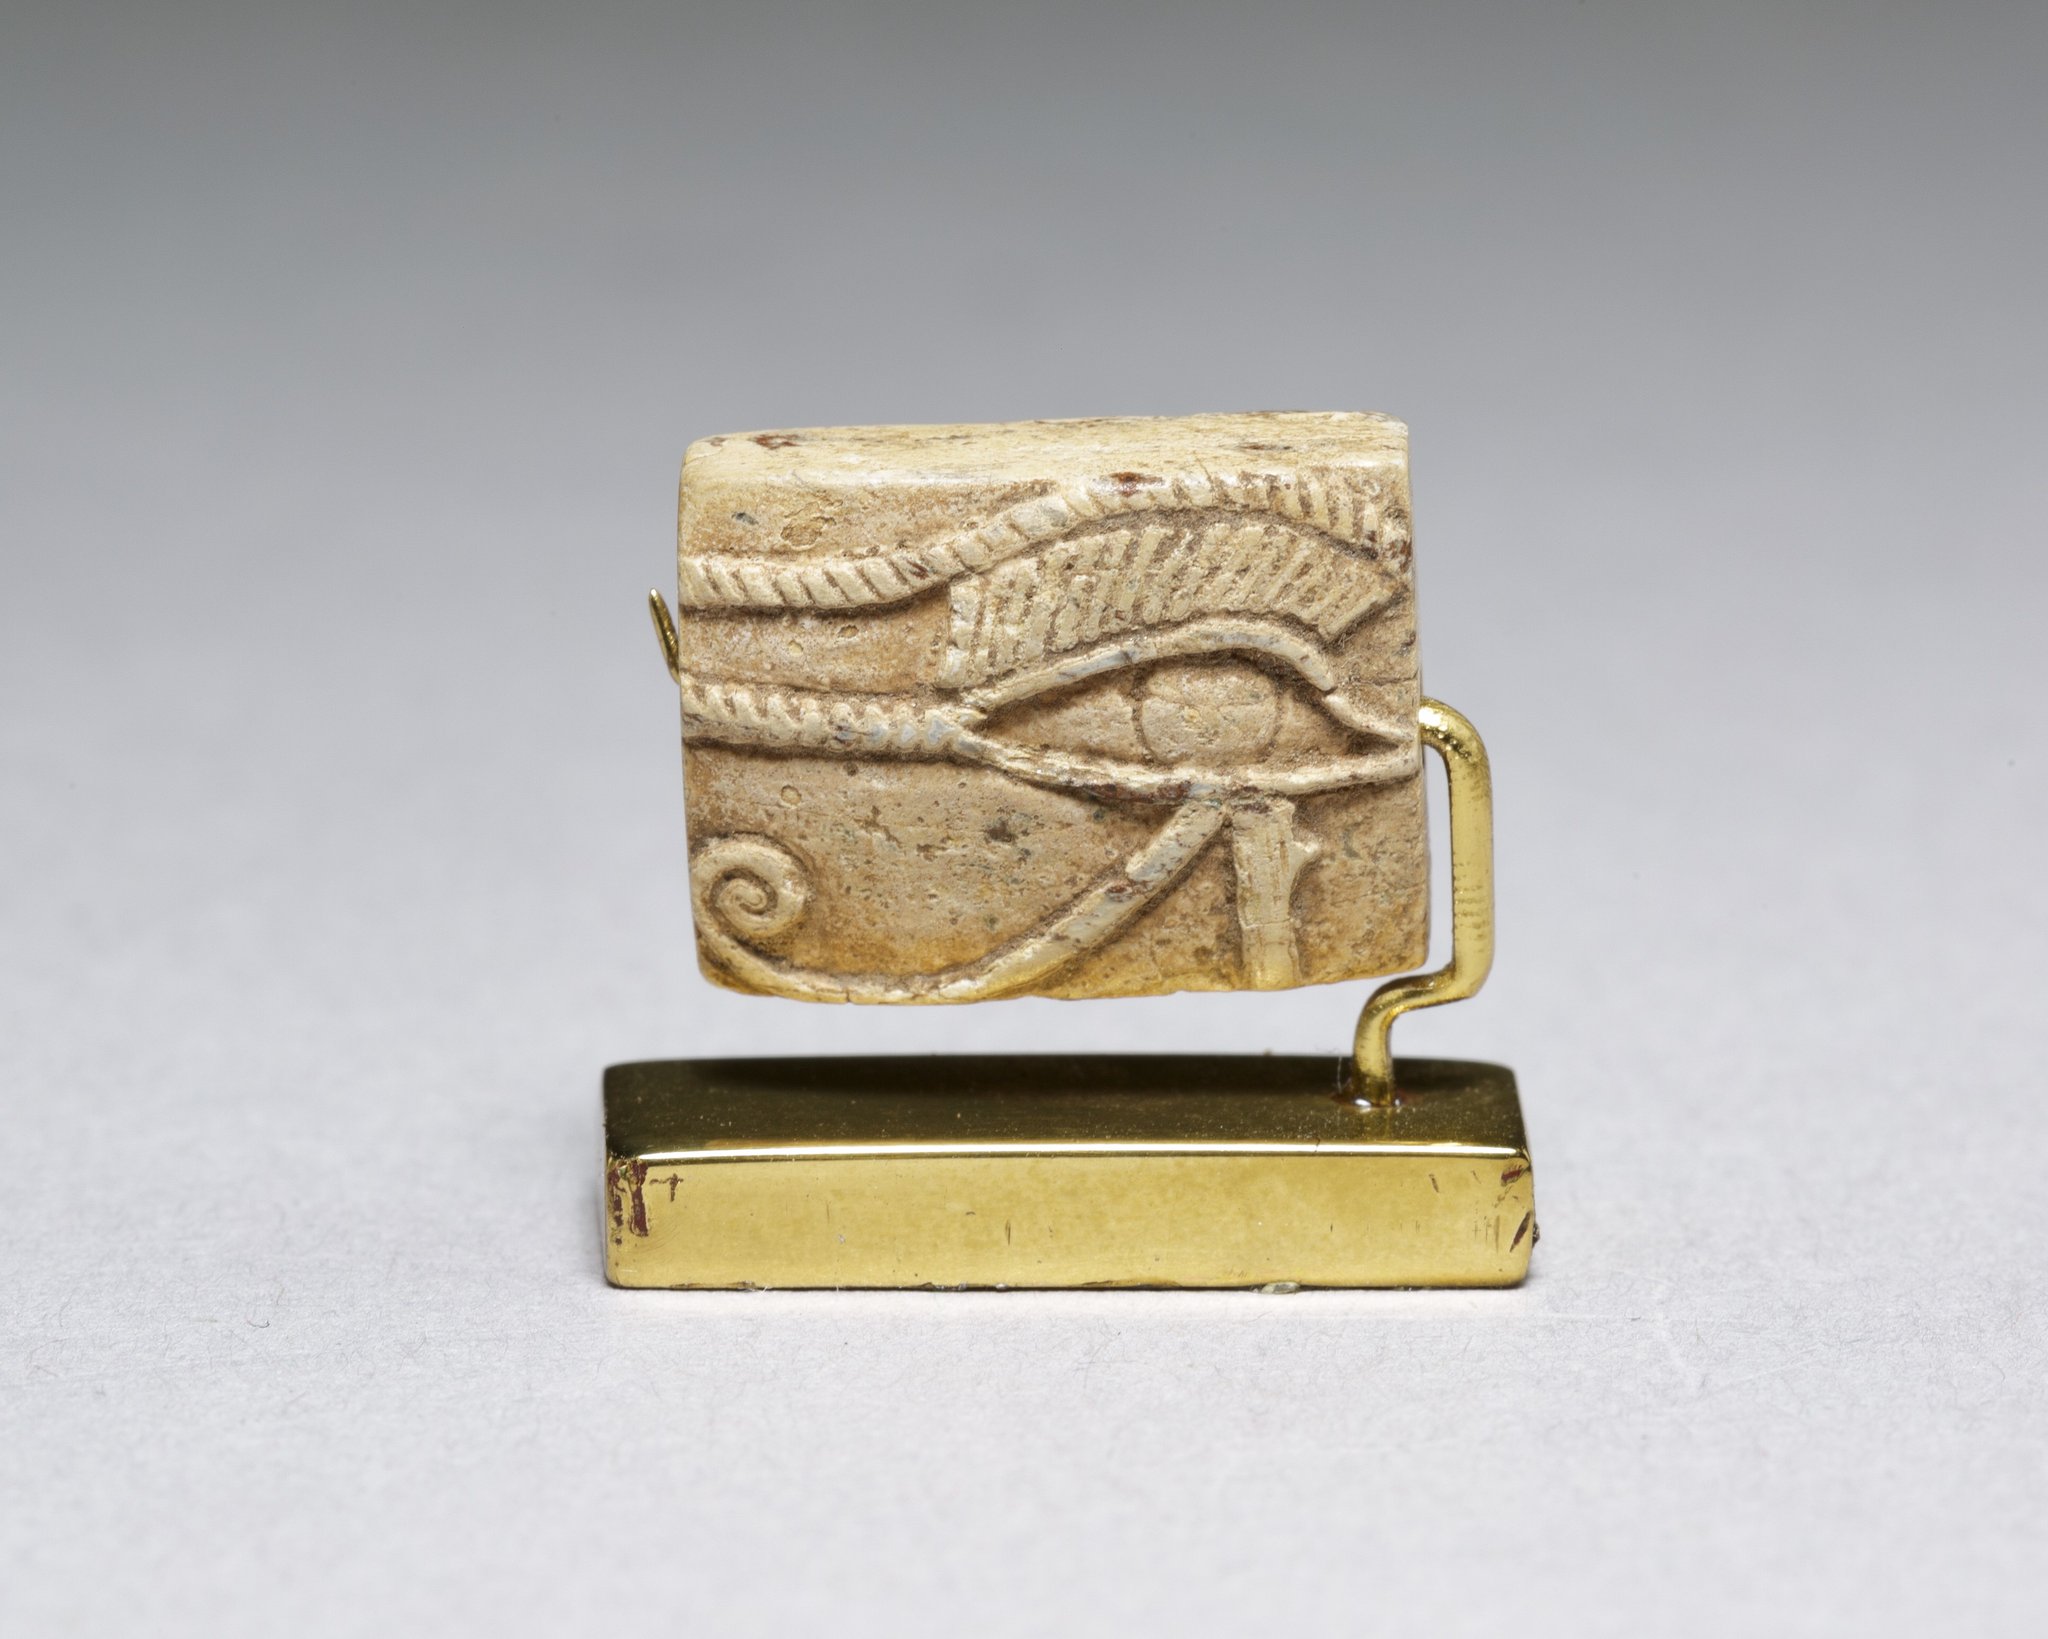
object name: amulet plaque, nebmaatre, serpent goddess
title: Wedjat Plaque; on opposite side Maat, Re, Upper and Lower Egyptian serpents over nub sign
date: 664-332 BCE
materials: stone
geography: egypt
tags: eyes